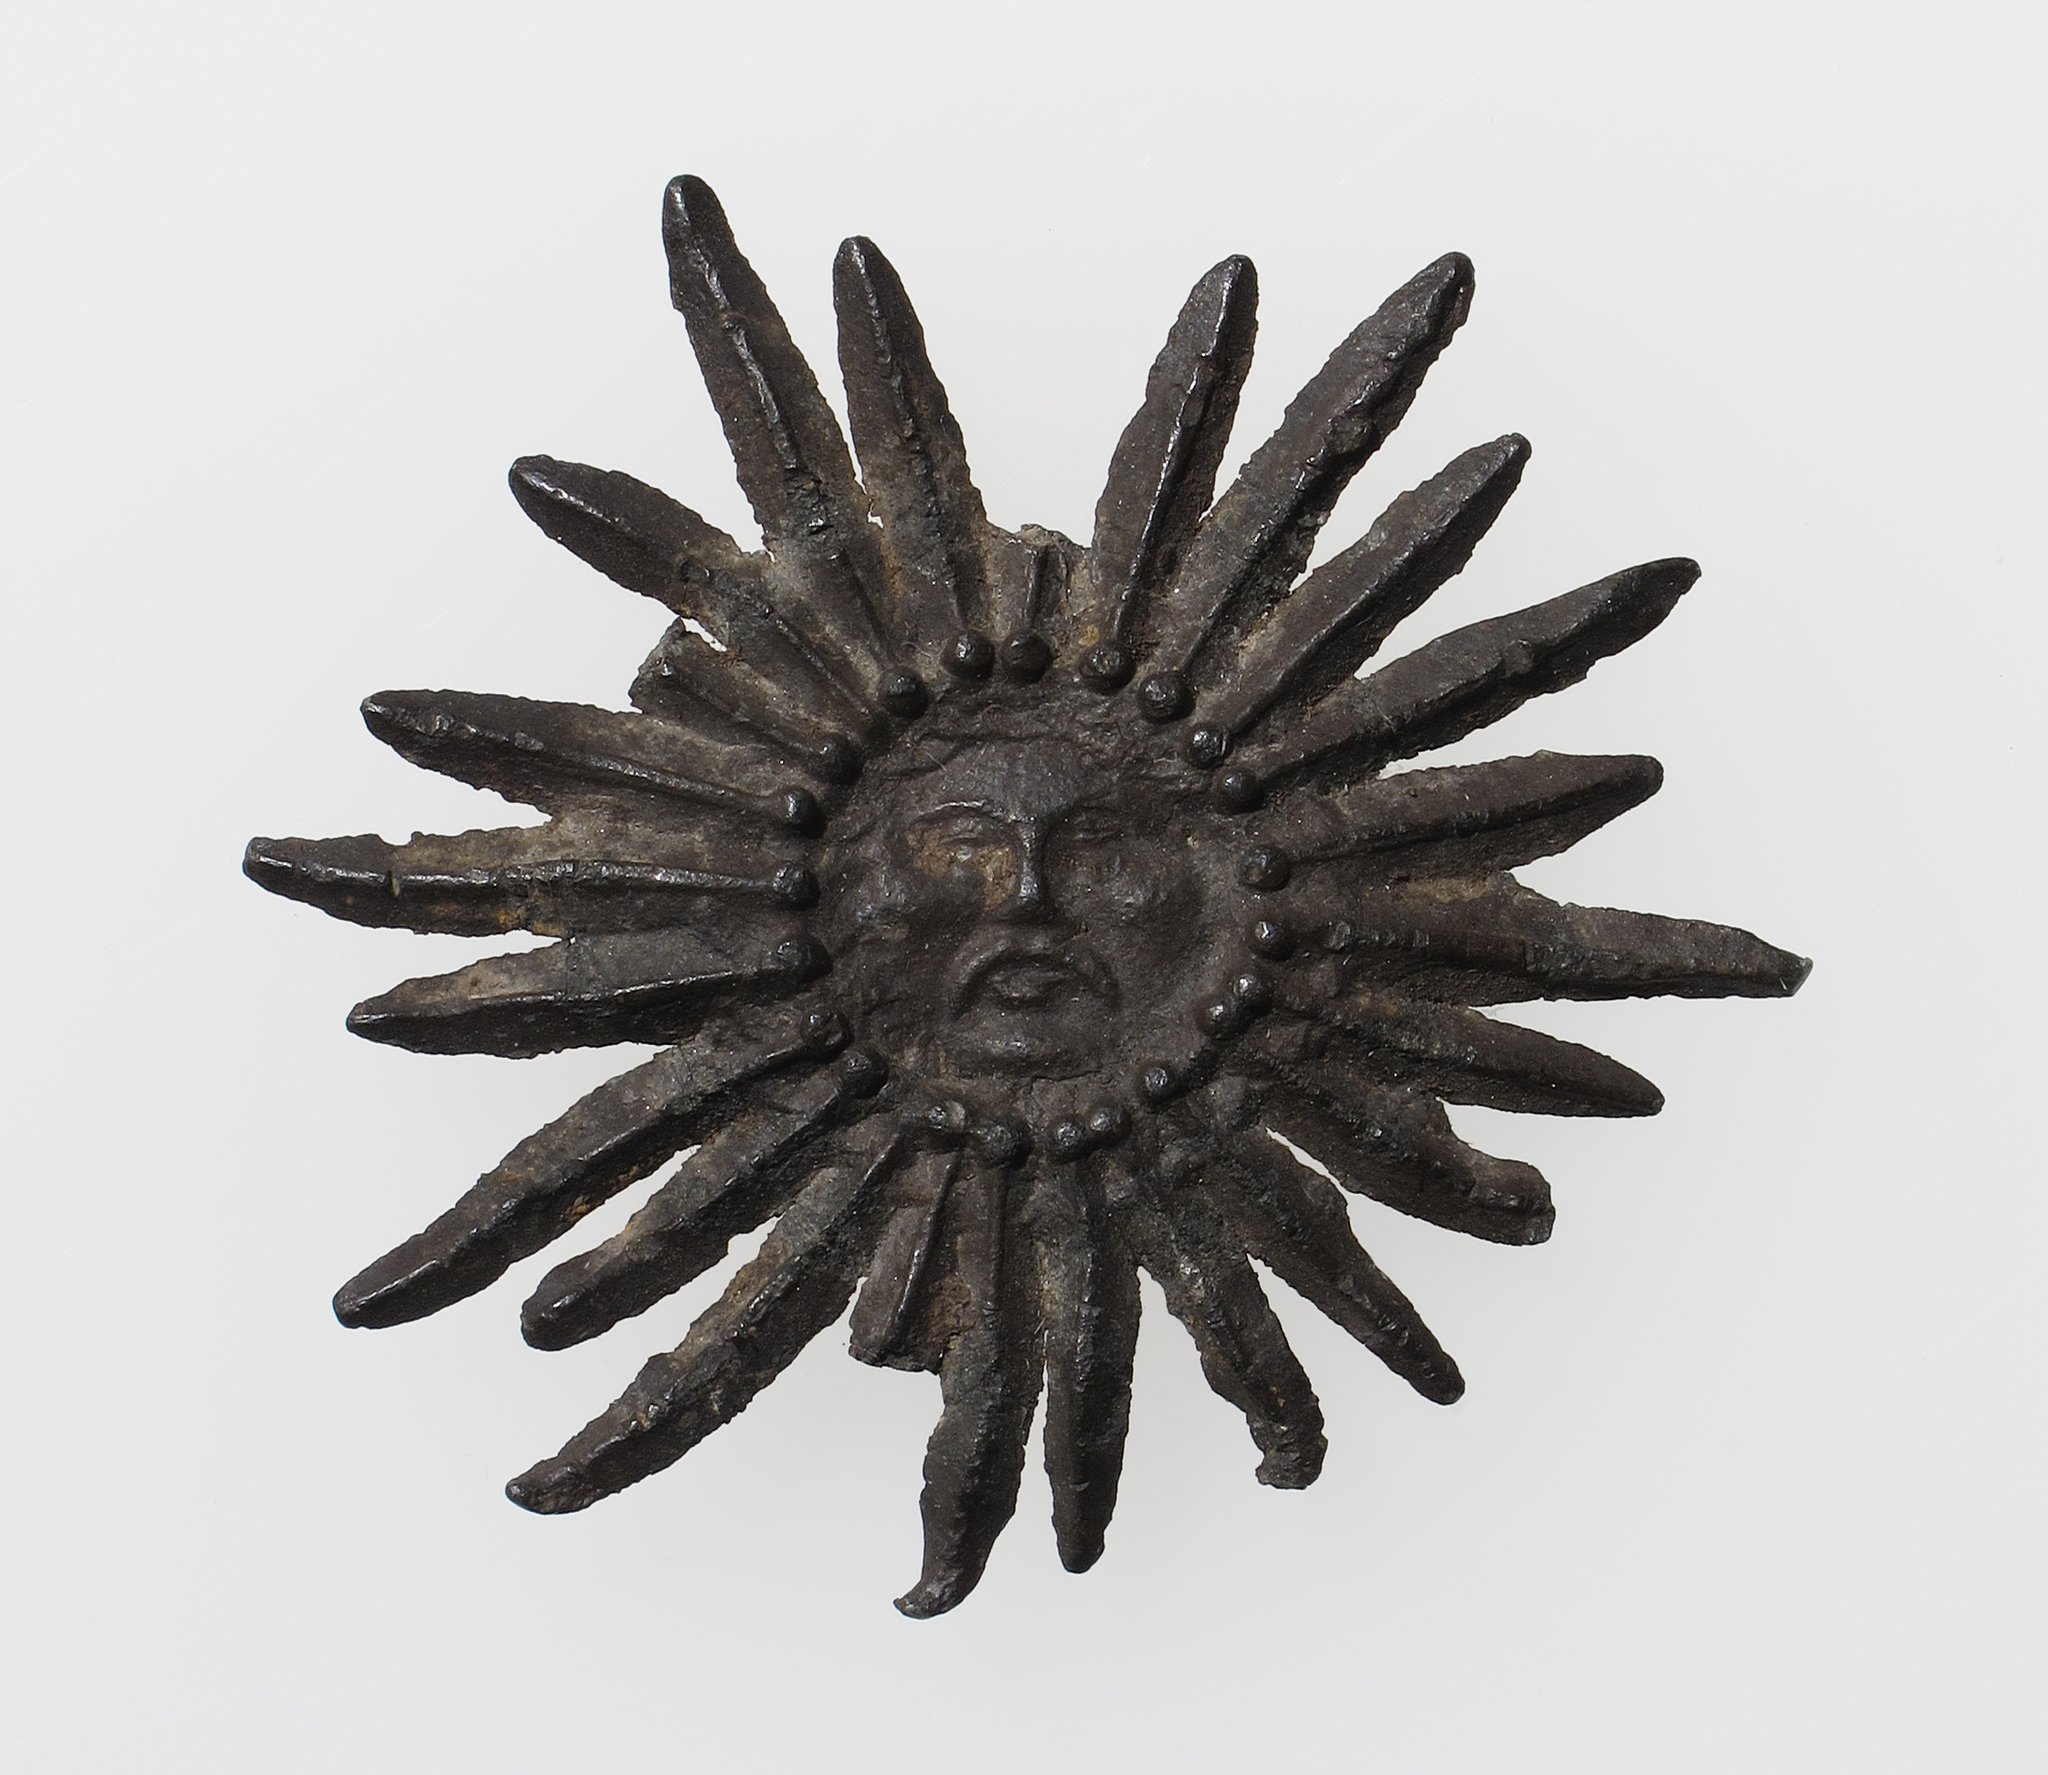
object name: pilgrim's badge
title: Pilgrim's Badge with Sun with human face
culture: french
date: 1401-1500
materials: lead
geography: france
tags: sun